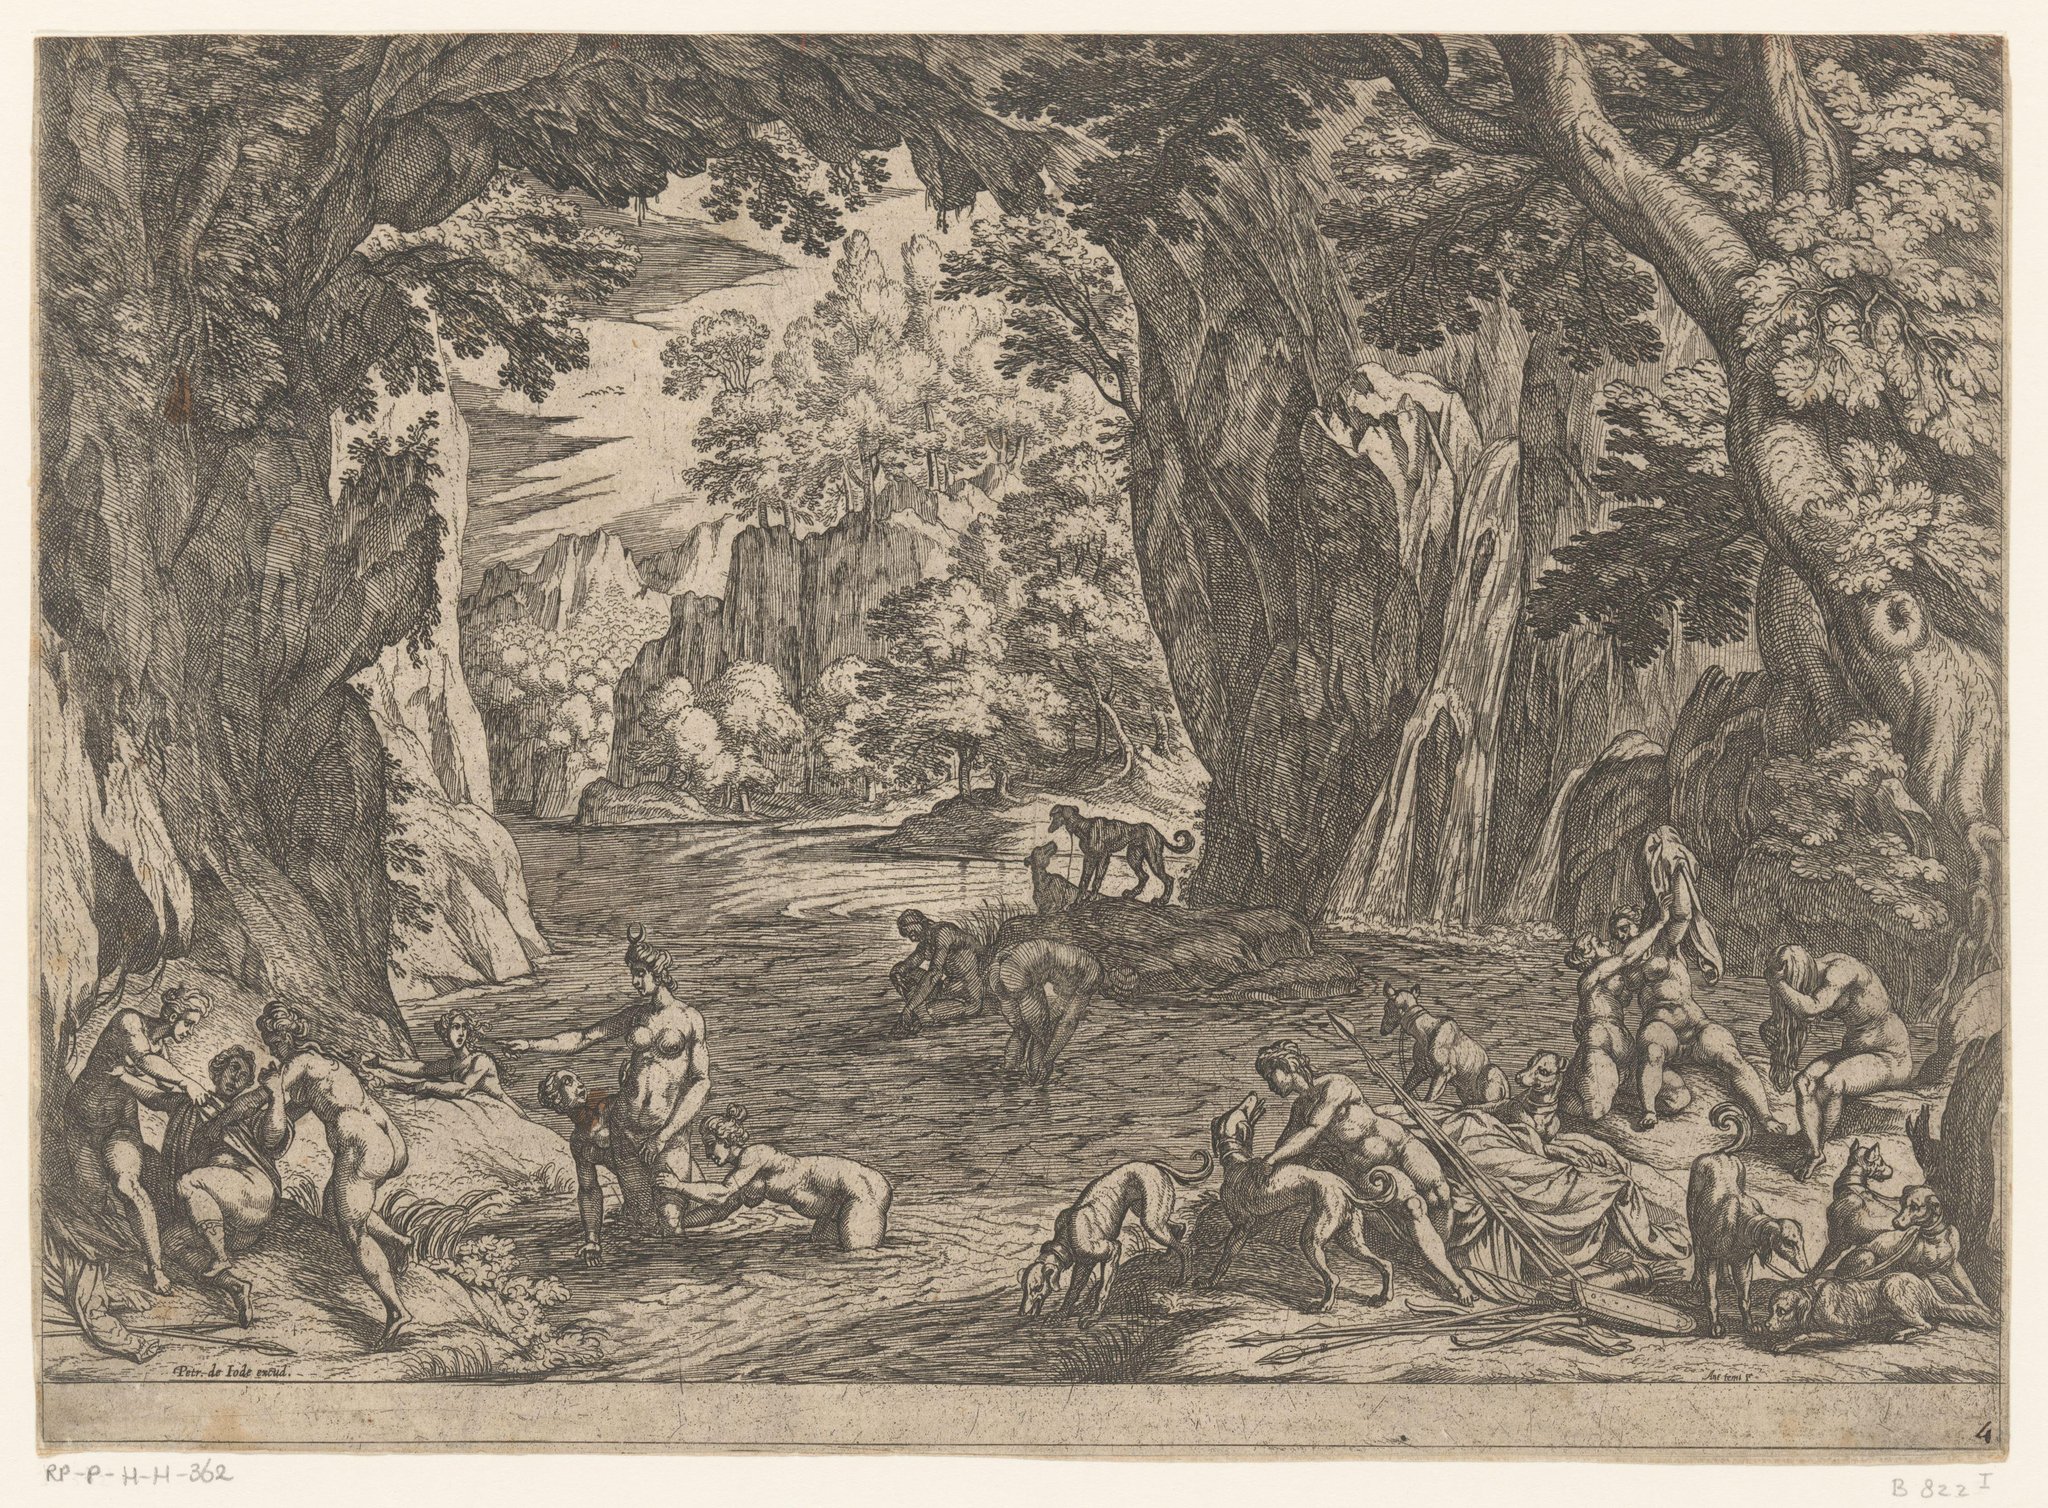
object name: print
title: Diana ontdekt de zwangerschap van Callisto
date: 1565-1630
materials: paper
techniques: etching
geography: italy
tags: diana with her nymphs discovers the pregnancy of callisto, pregnancy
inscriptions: collector's mark: ‘Hinloopen’, collector's mark: Lugt 11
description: Landschap met bomen, een grot en water. Diana en haar nimfen baden in het water. Op de voorgrond links ontdekt Diana de zwangerschap van de nimf Callisto.